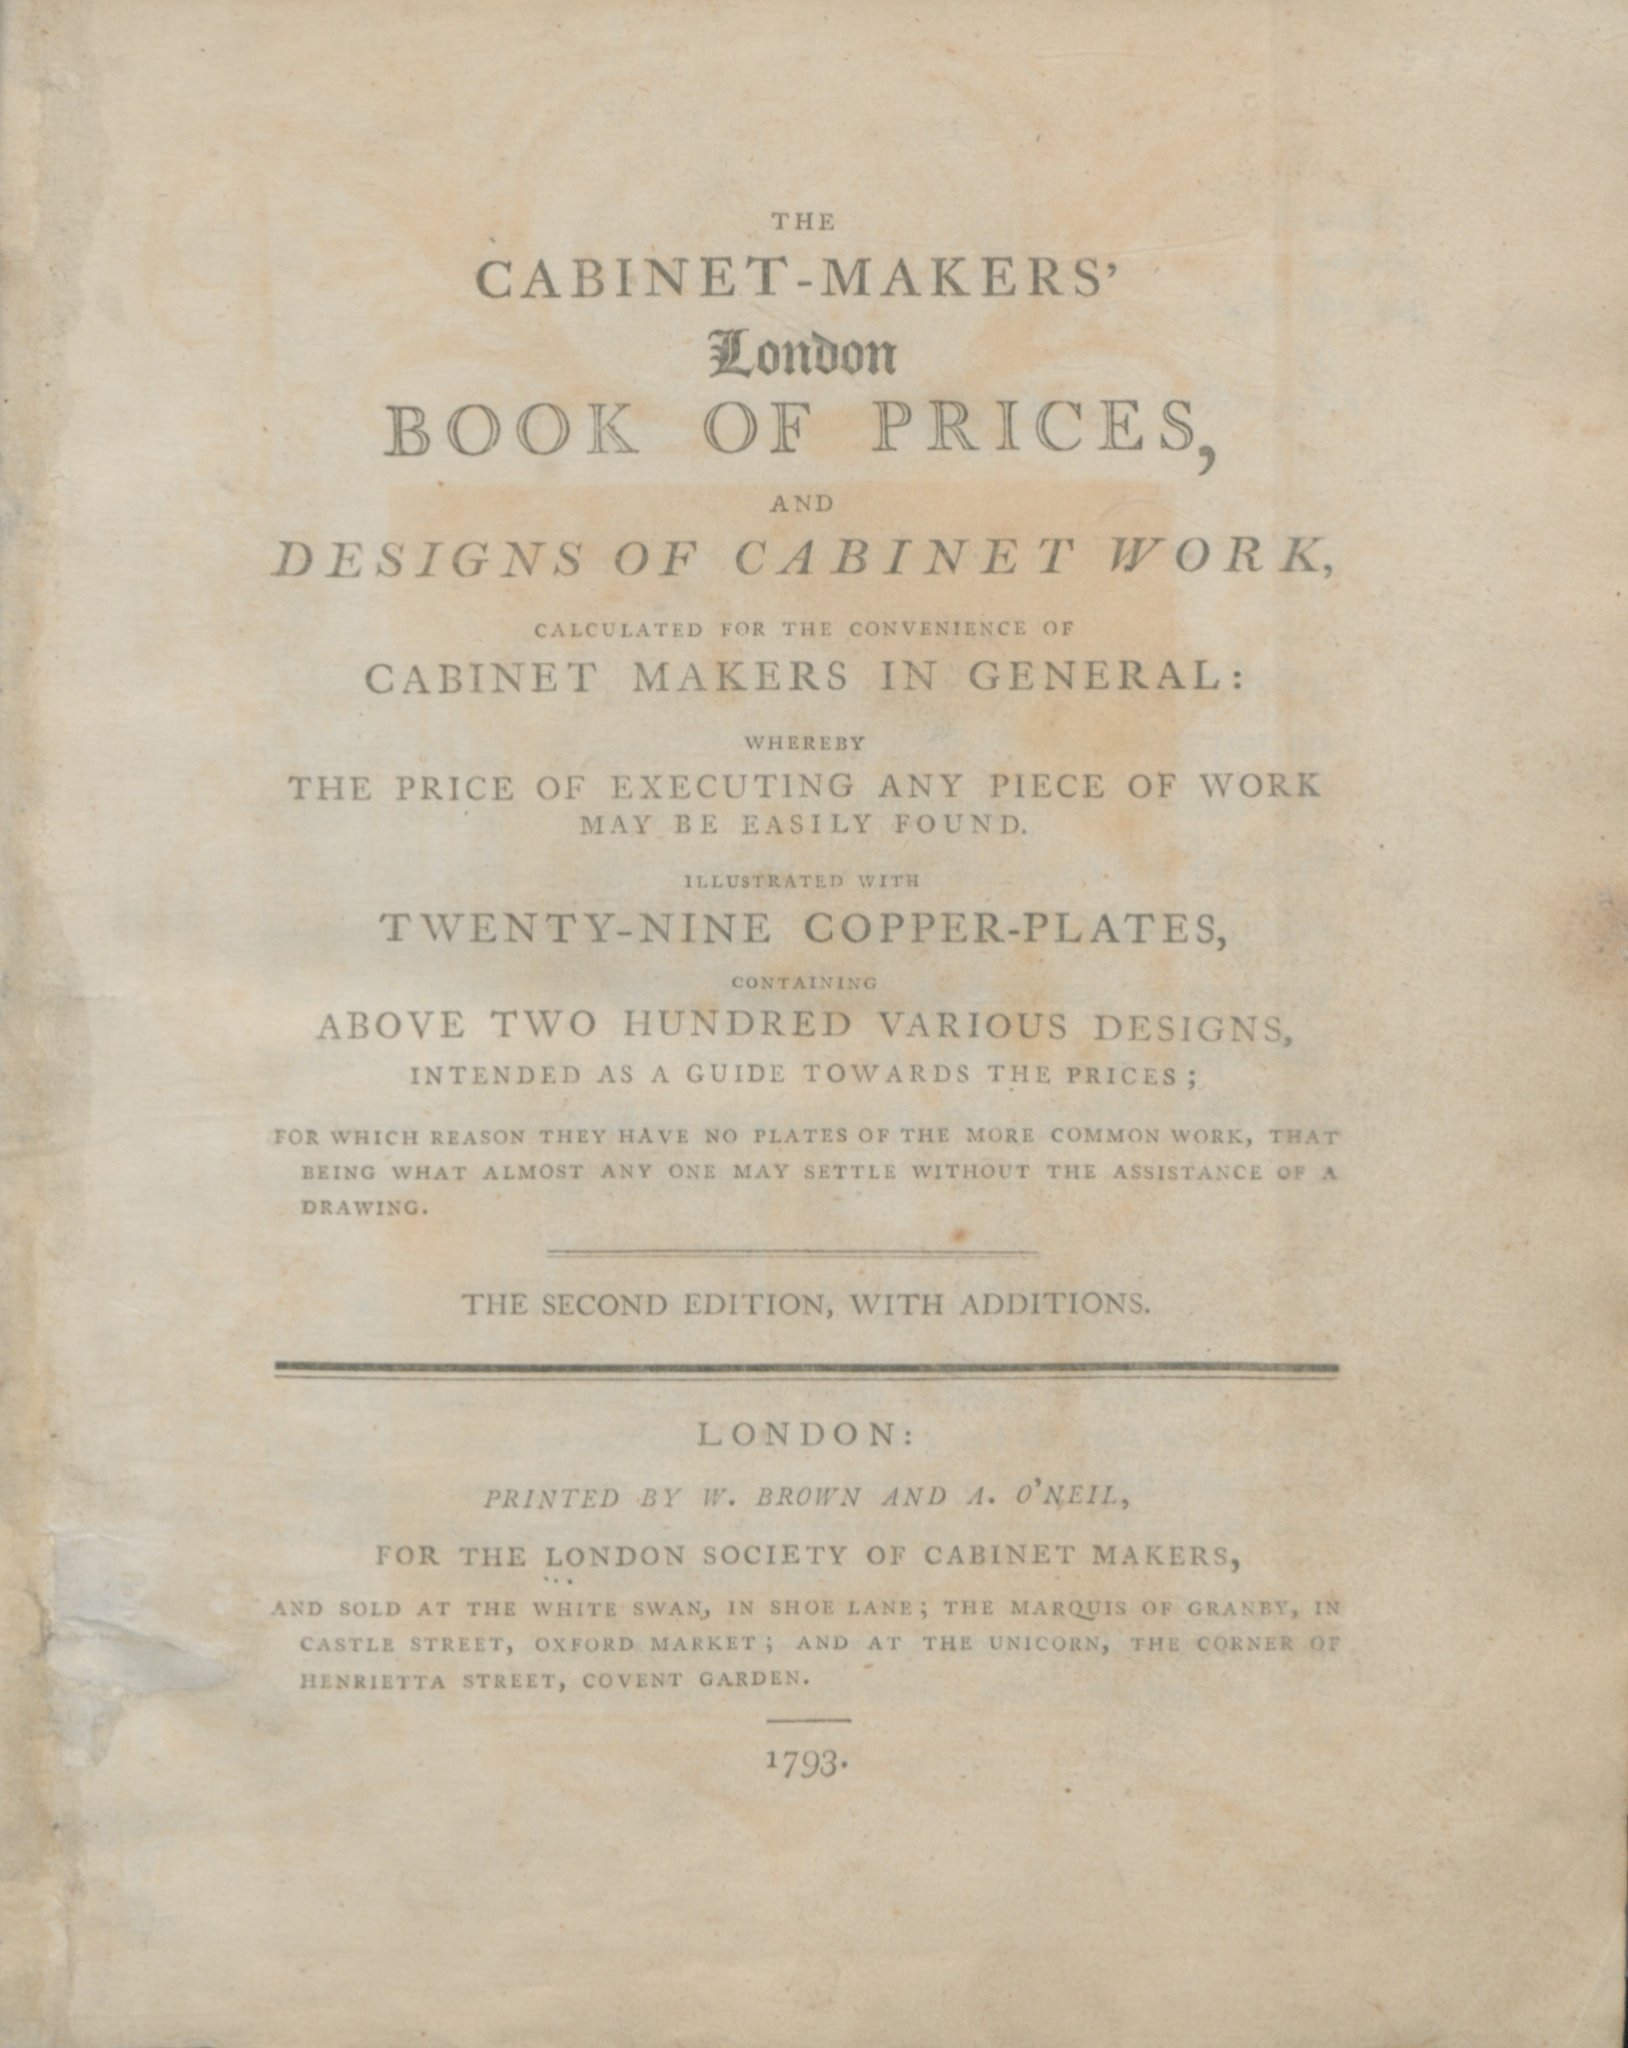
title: The cabinet-makers' London book of prices, and designs of cabinet work, calculated for the convenience of cabinet makers in general, whereby the price of executing any piece of work may be easily found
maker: london society of cabinet makers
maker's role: author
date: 1793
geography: london